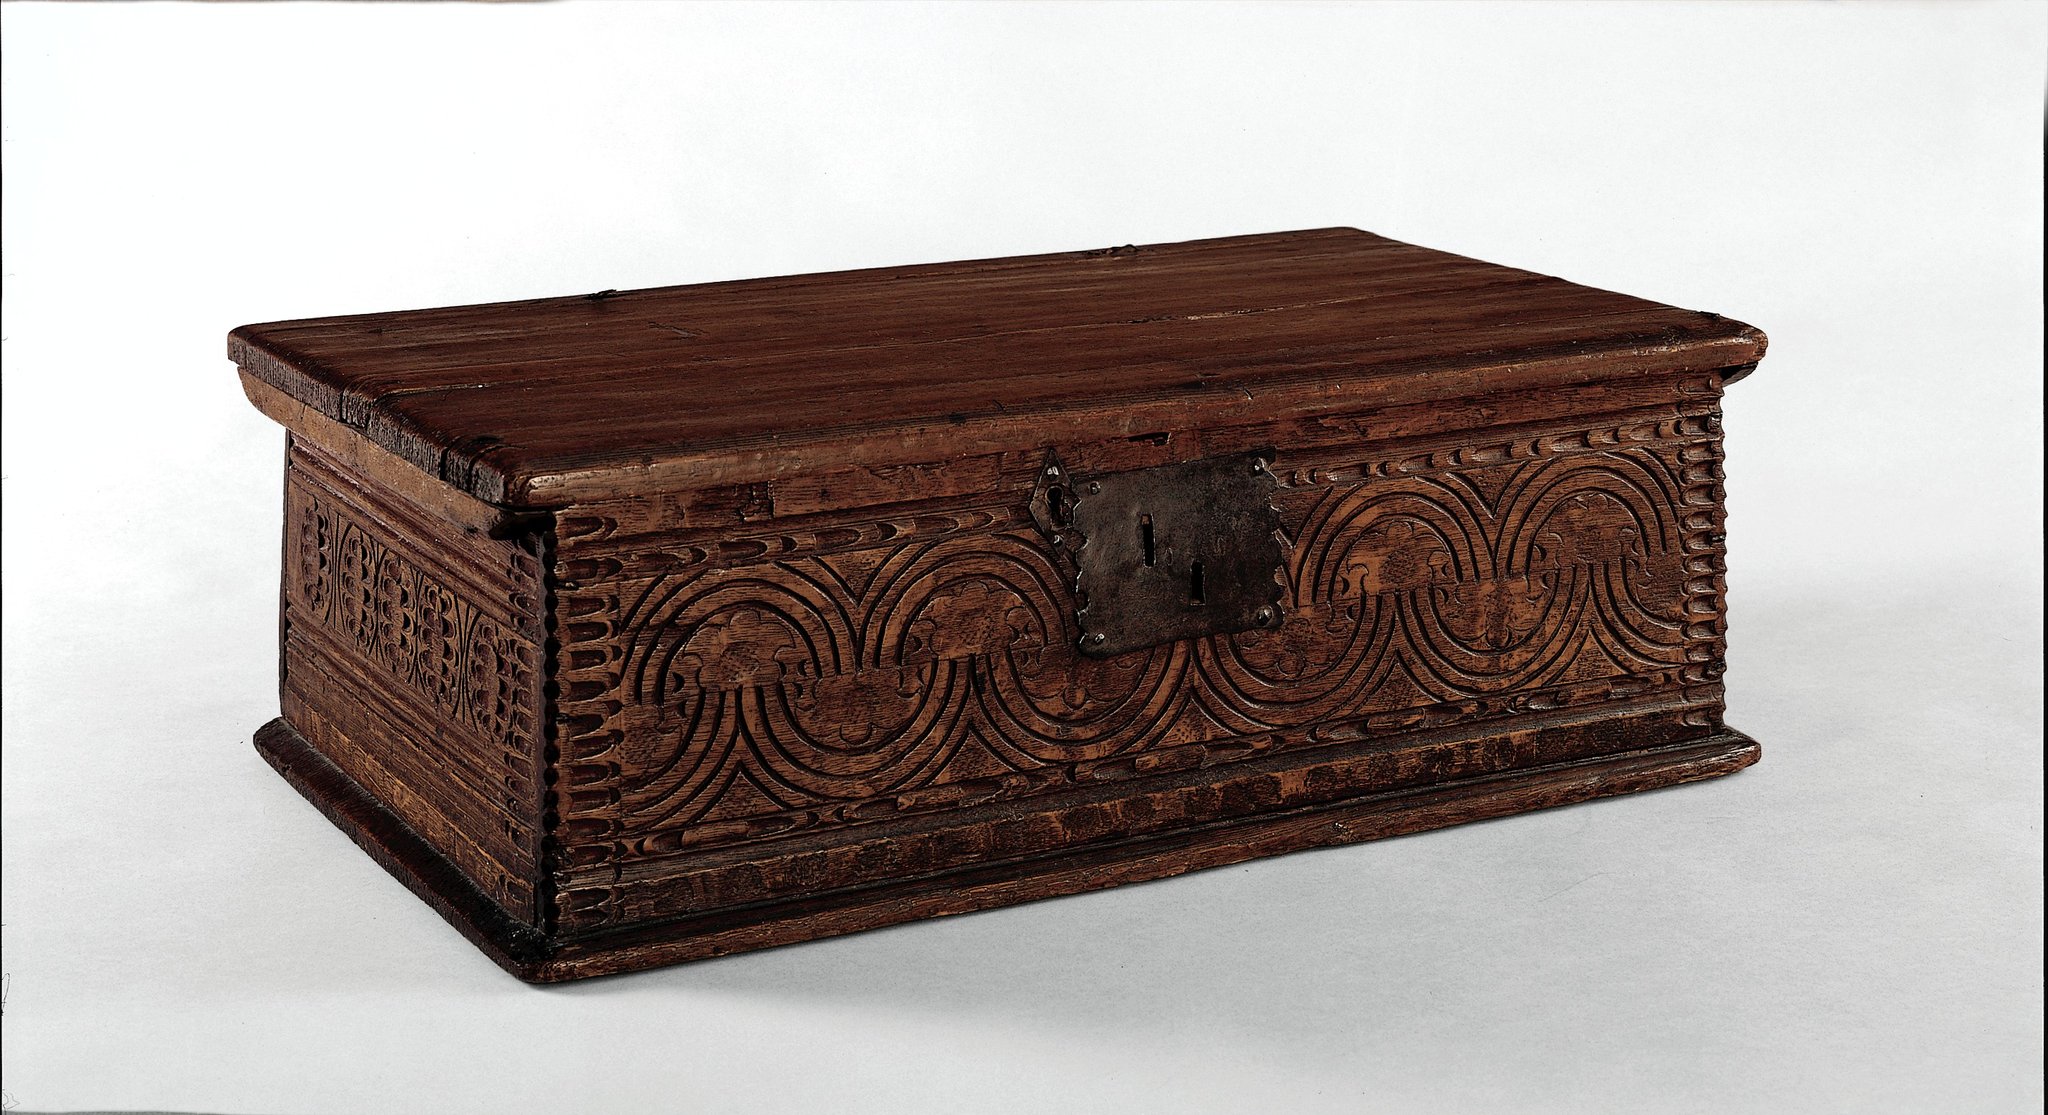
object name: box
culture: american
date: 1675-1700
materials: wood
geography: united states